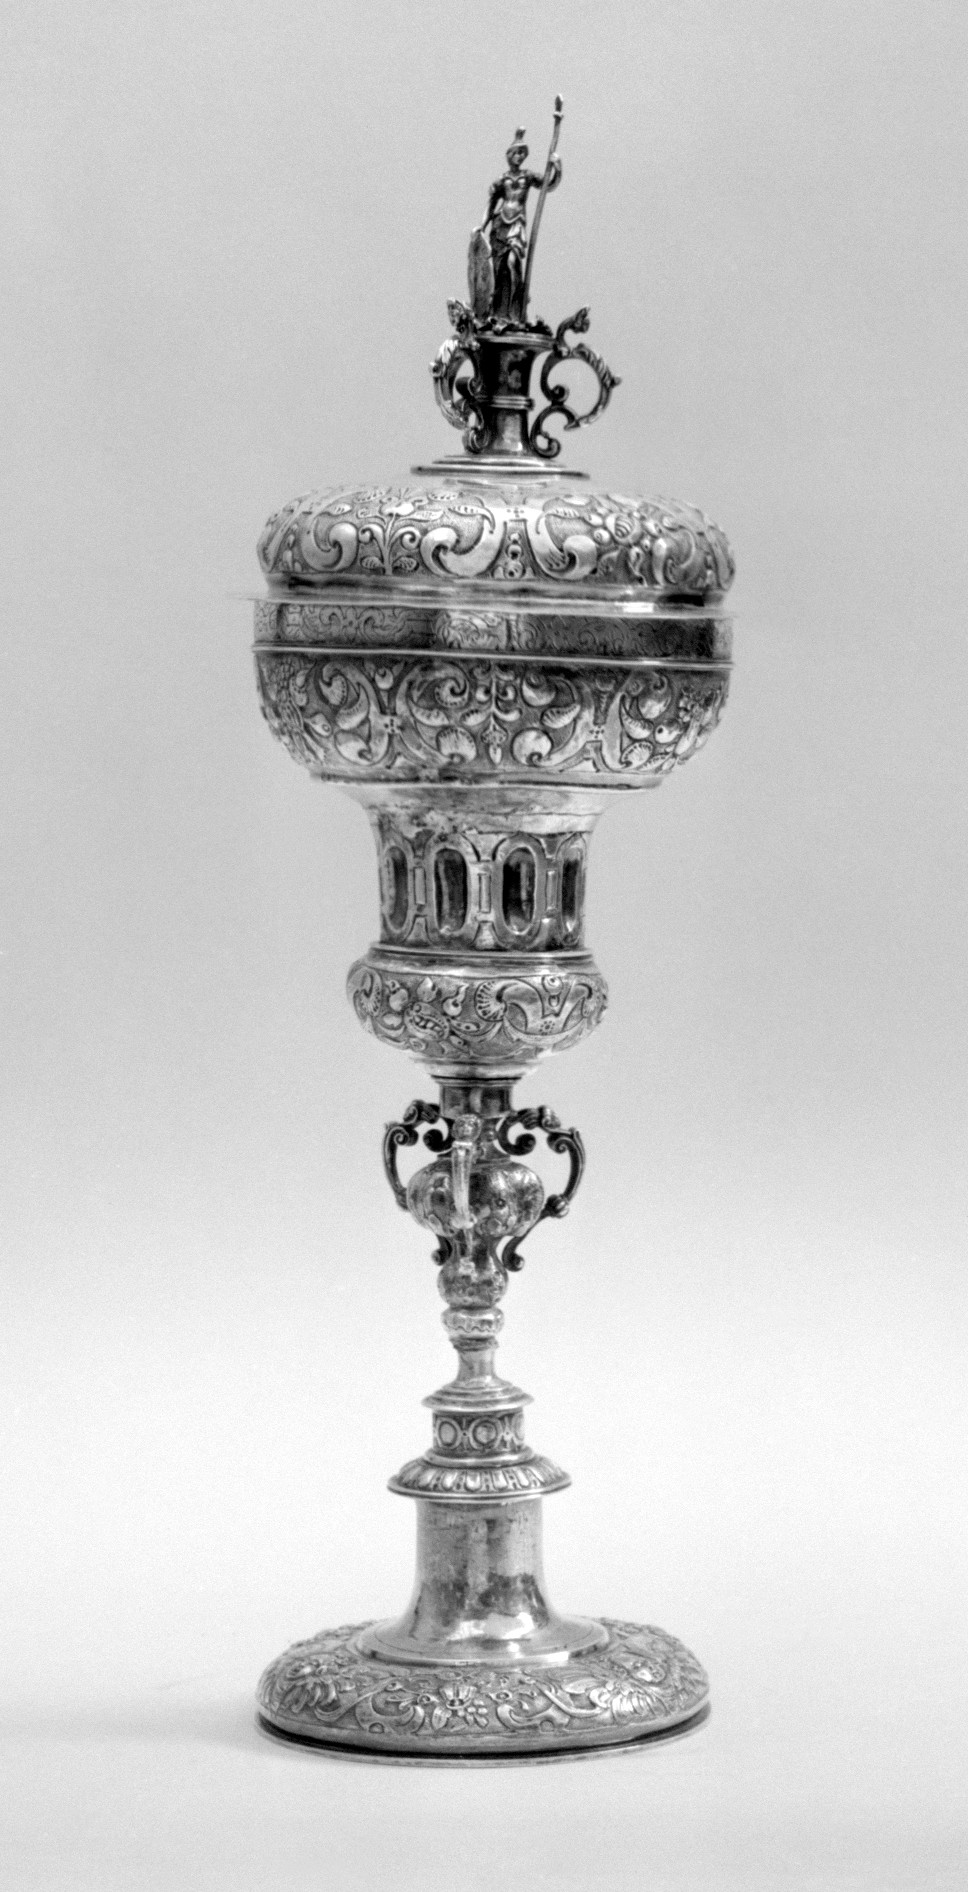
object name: cup with cover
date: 1600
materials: silver gilt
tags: men